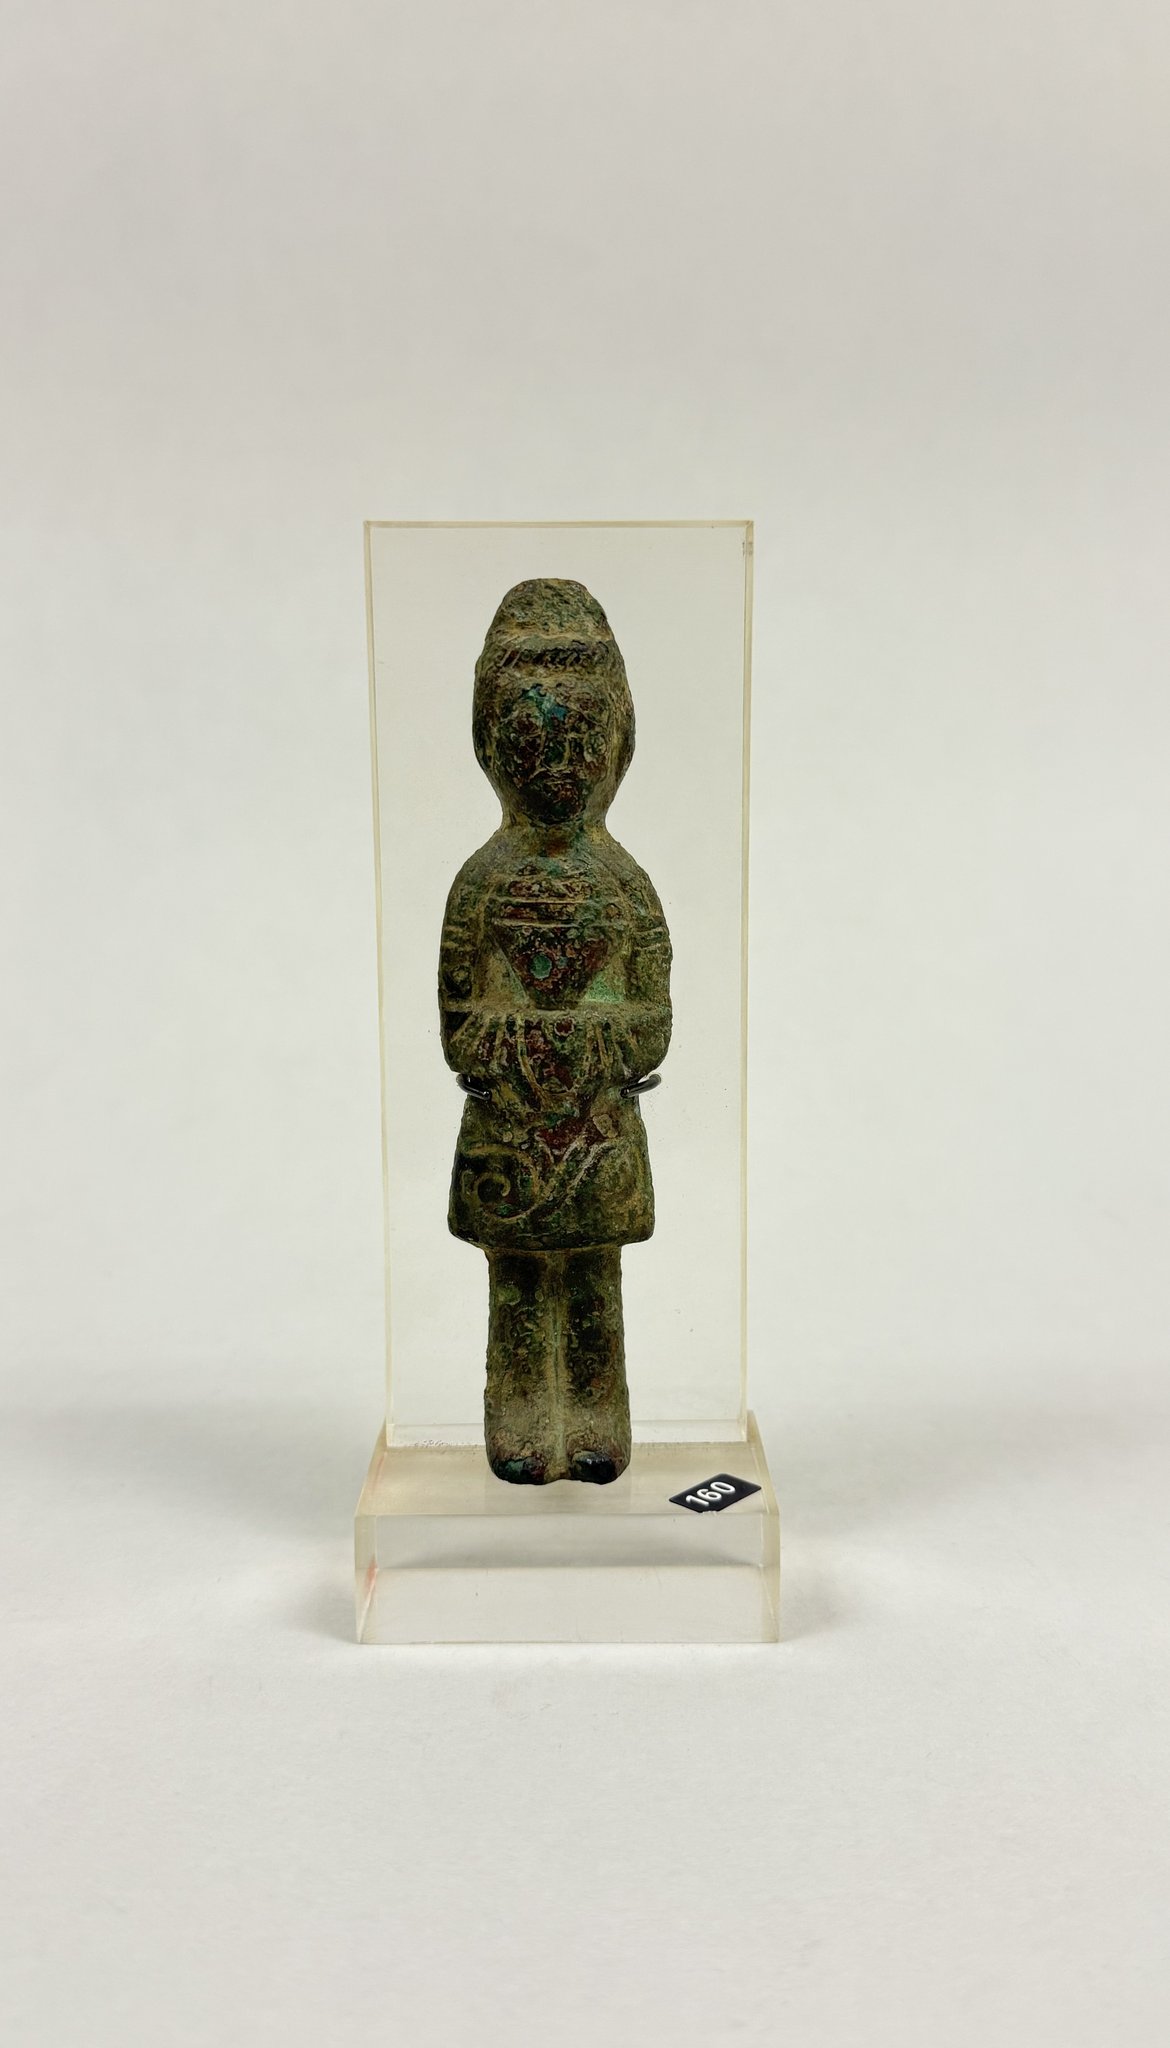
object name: figure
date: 500 BCE-300 CE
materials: bronze